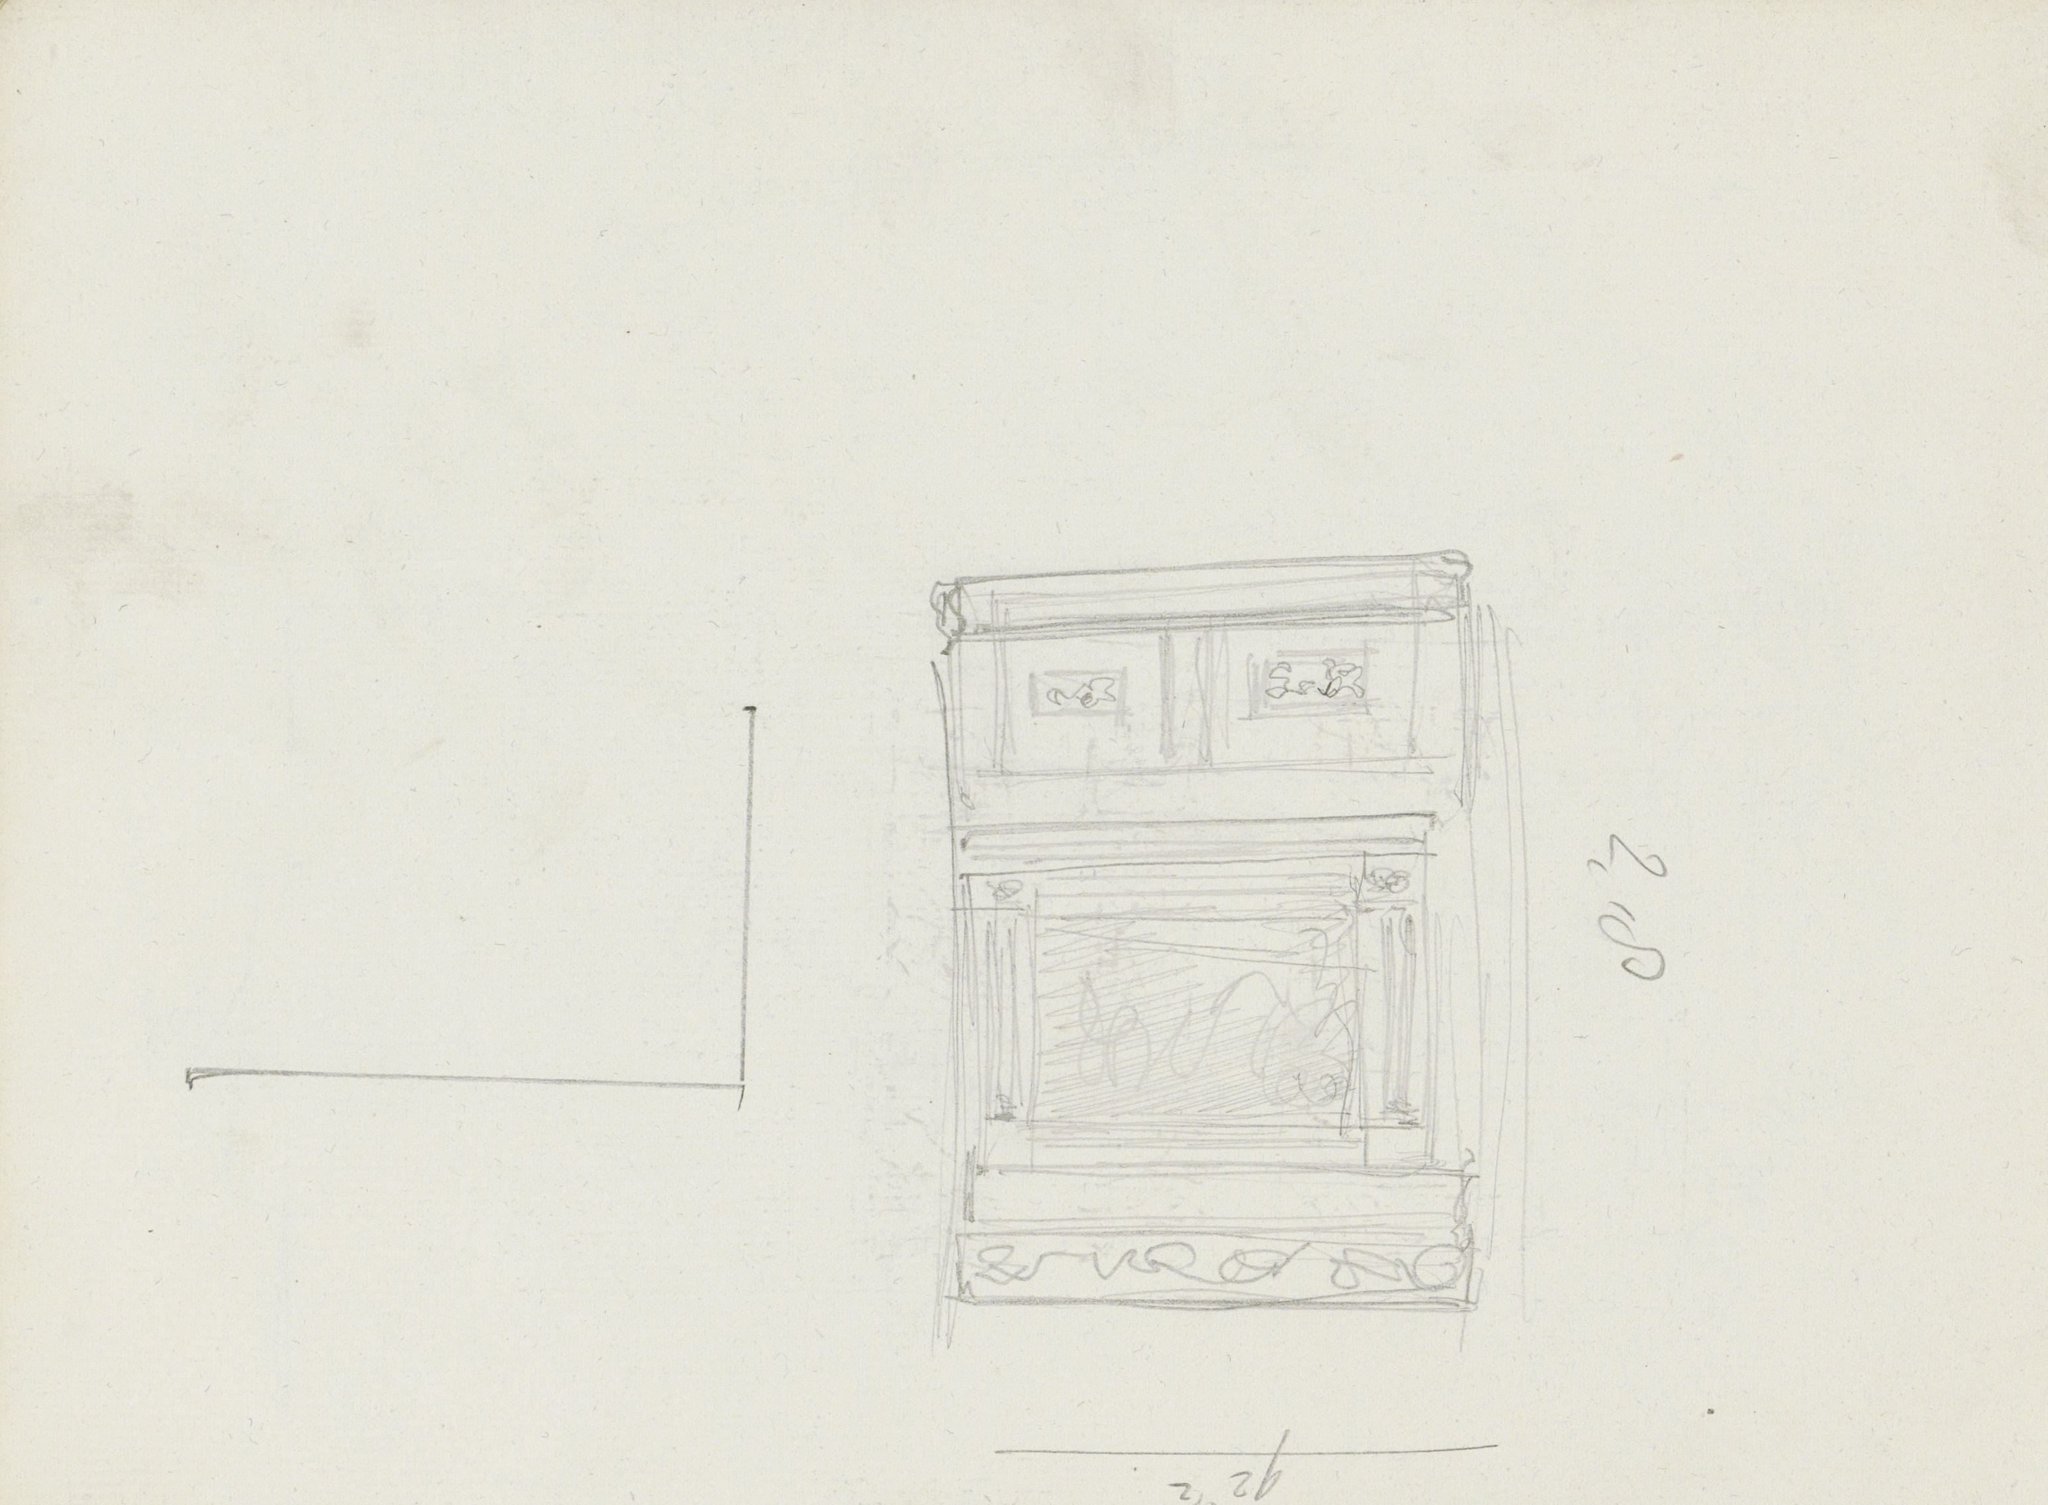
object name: sketchbook leaf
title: Ontwerp voor wanddecoratie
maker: carel adolph lion cachet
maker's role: draughtsman, print maker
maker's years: 1864-1945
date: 1905-1910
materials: paper, pencil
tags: containers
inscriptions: annotation: ‘[...]’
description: Blad 16 verso uit een schetsboek met 27 bladen.